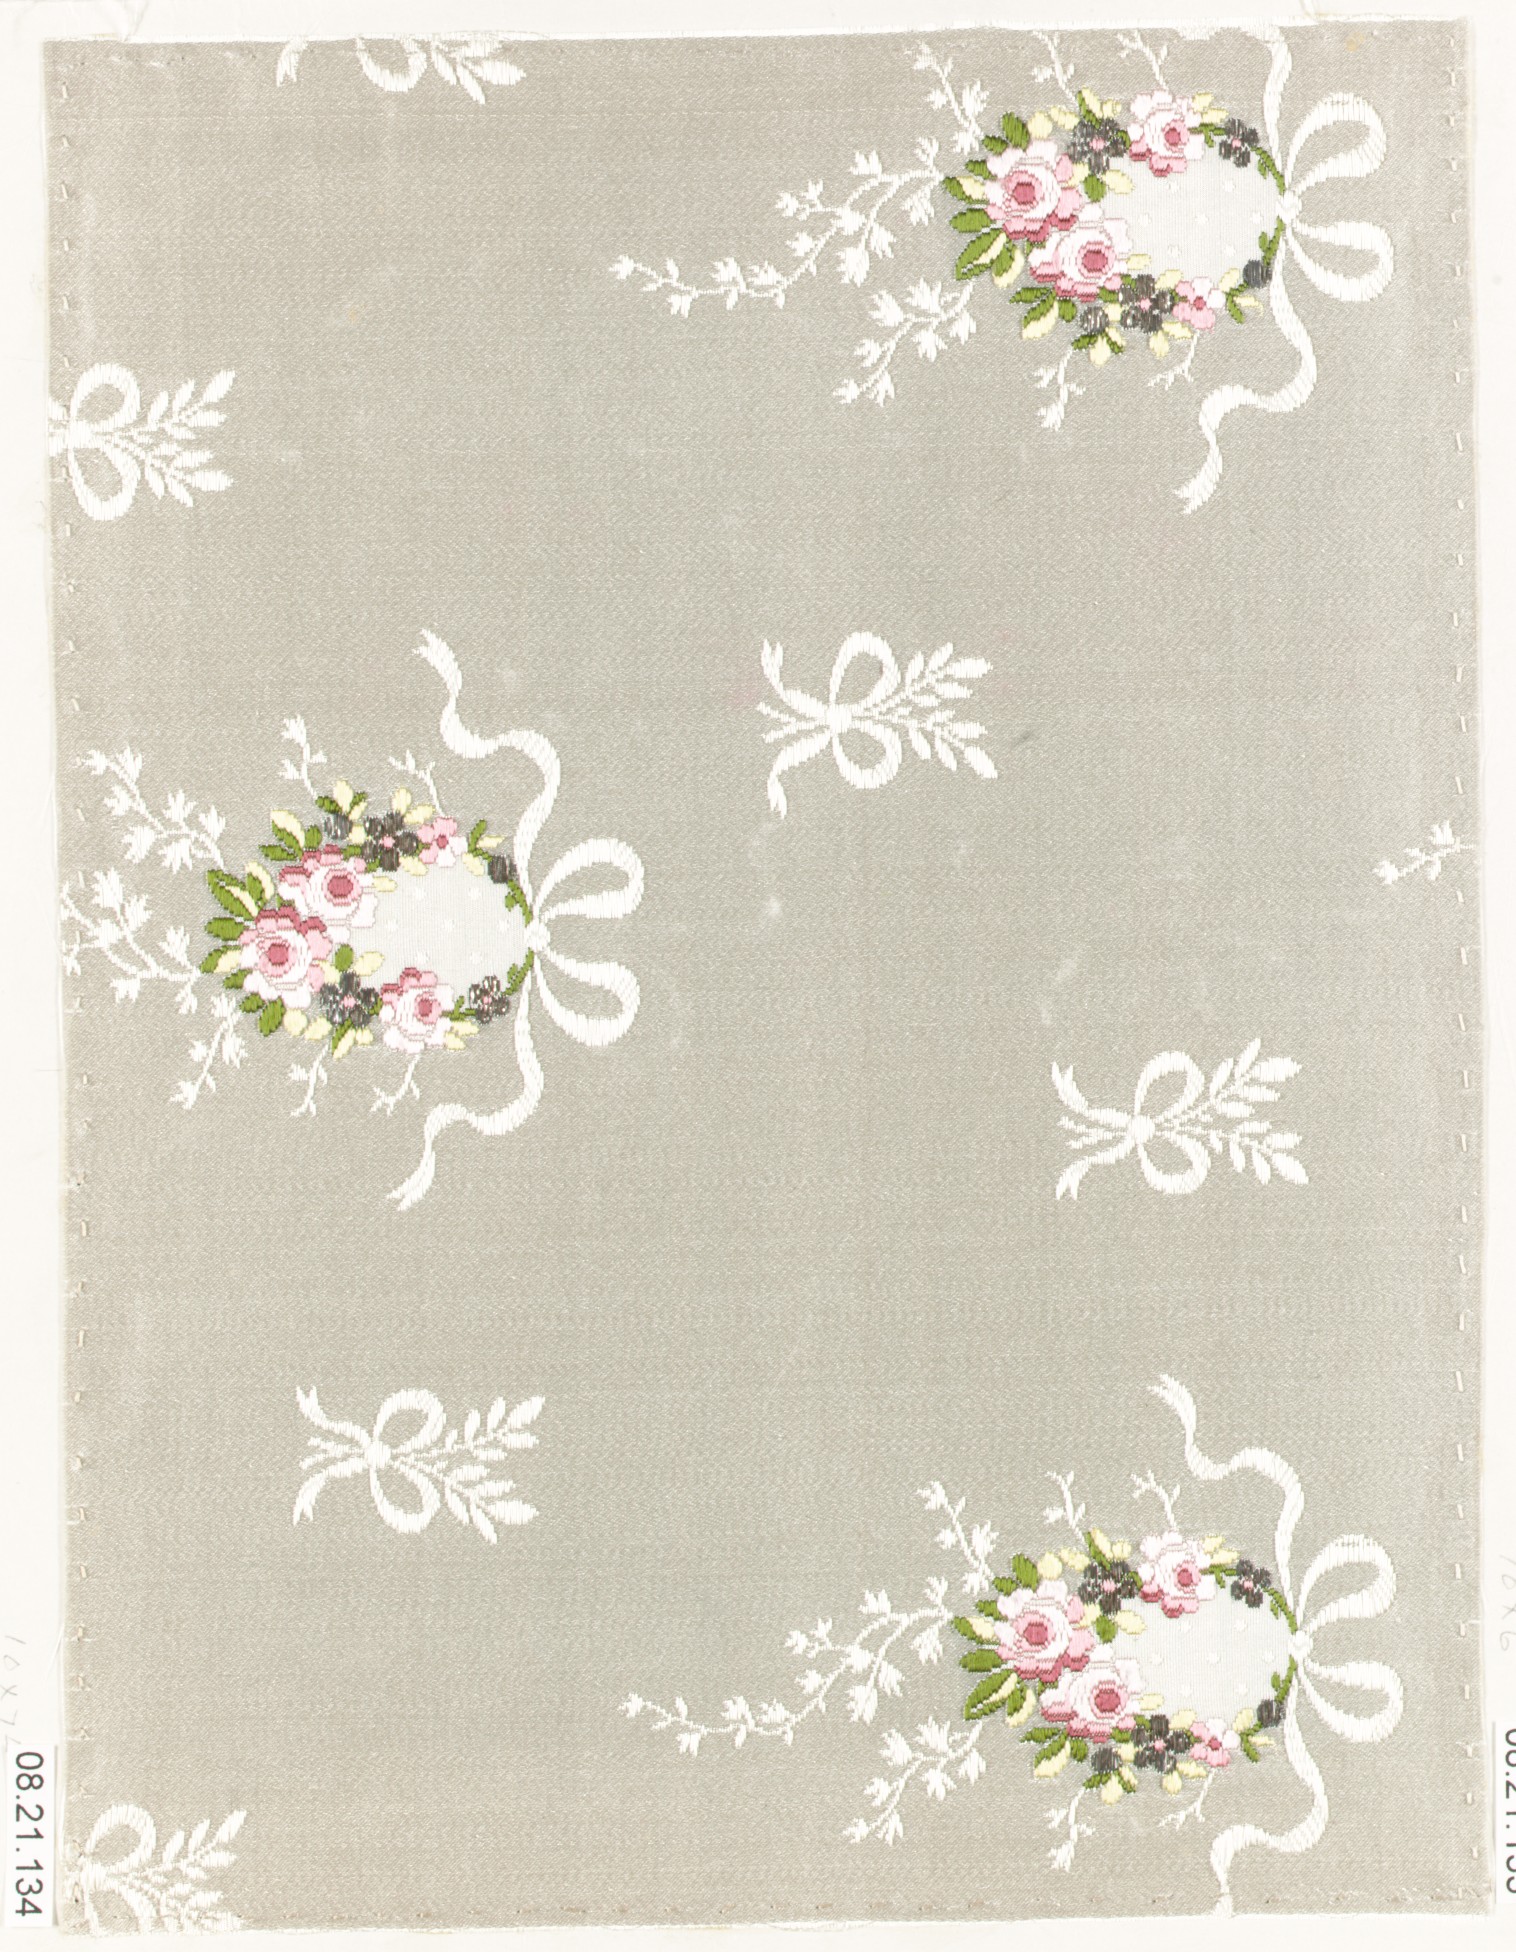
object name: textile sample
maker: Anonymous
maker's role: designer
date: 1900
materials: silk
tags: flowers